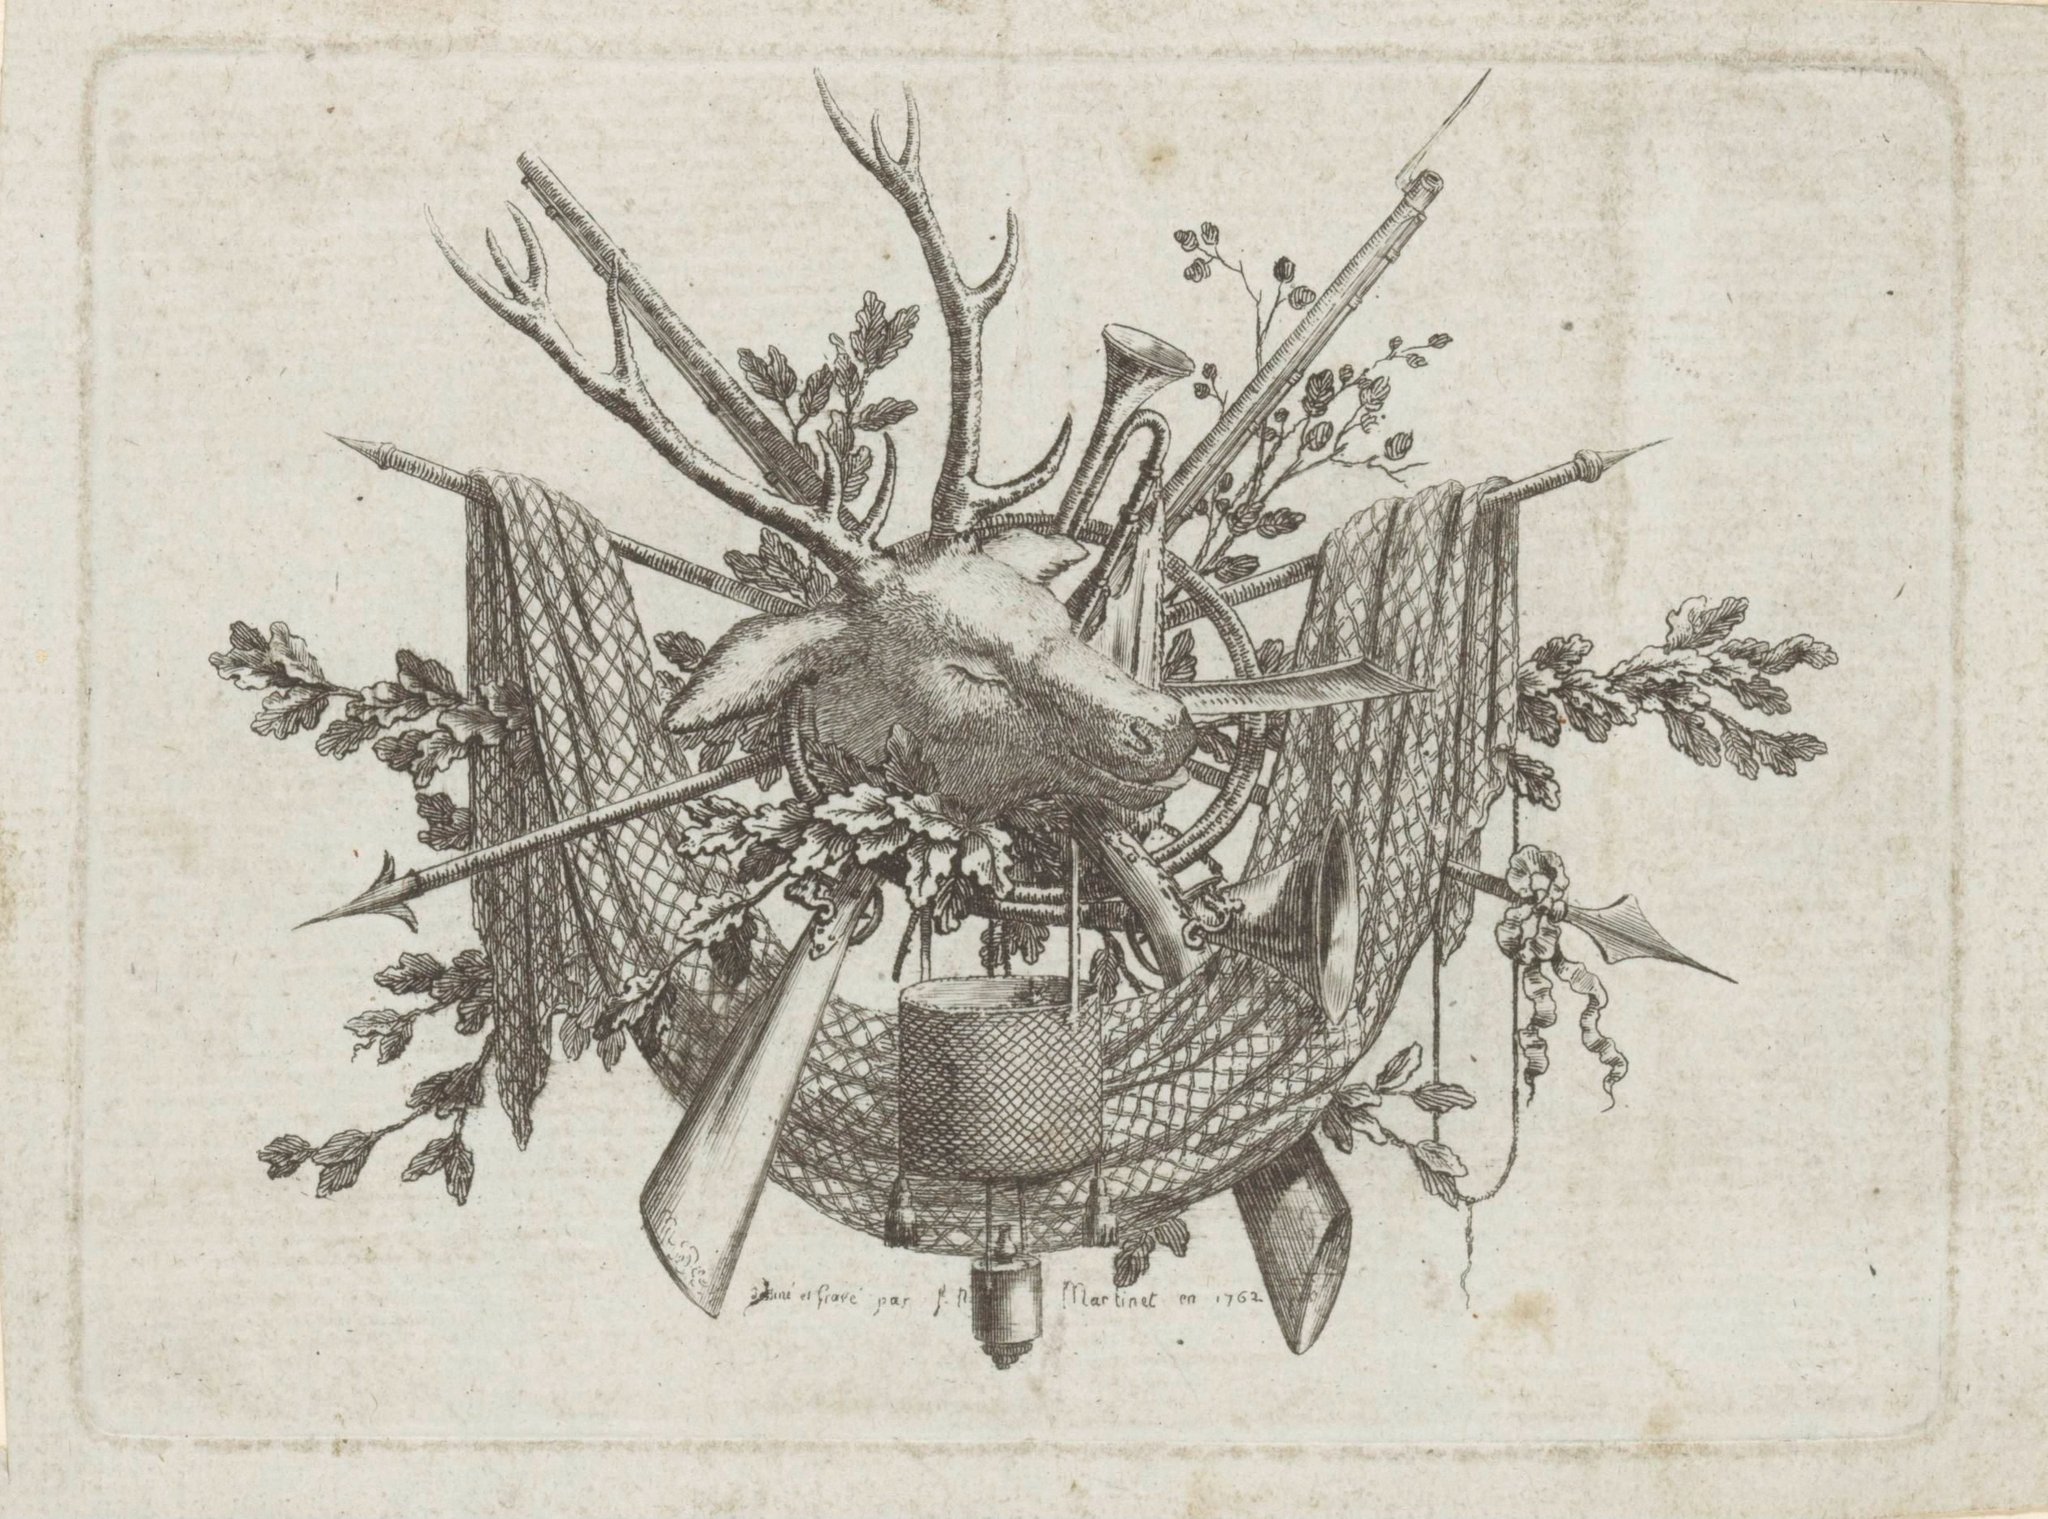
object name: ornament print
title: Jachttrofee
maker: françois nicolas martinet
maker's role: print maker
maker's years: 1731-1787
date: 1762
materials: paper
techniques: etching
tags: hunting trophies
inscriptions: collector's mark: Lugt 2760, collector's mark: Lugt 2228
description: Een jachttrofee met een hertenkop, geweren, speren, een trompet, een jachthoorn en een net.